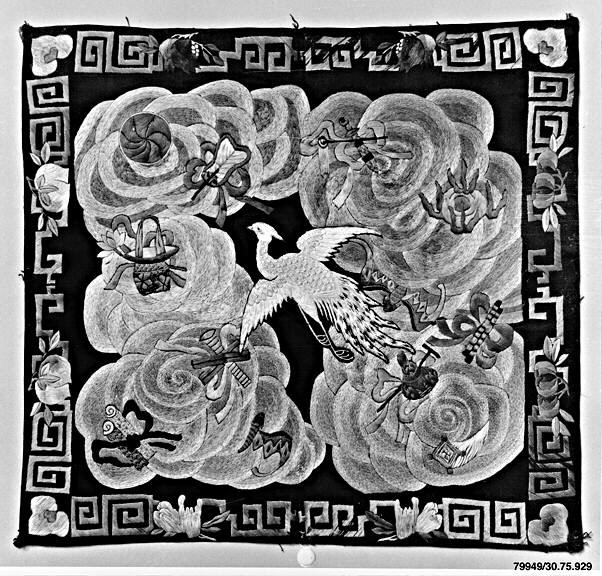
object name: rank badge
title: Rank Badge with Silver Pheasant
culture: chinese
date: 1767-1833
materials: metal thread, silk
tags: pheasants